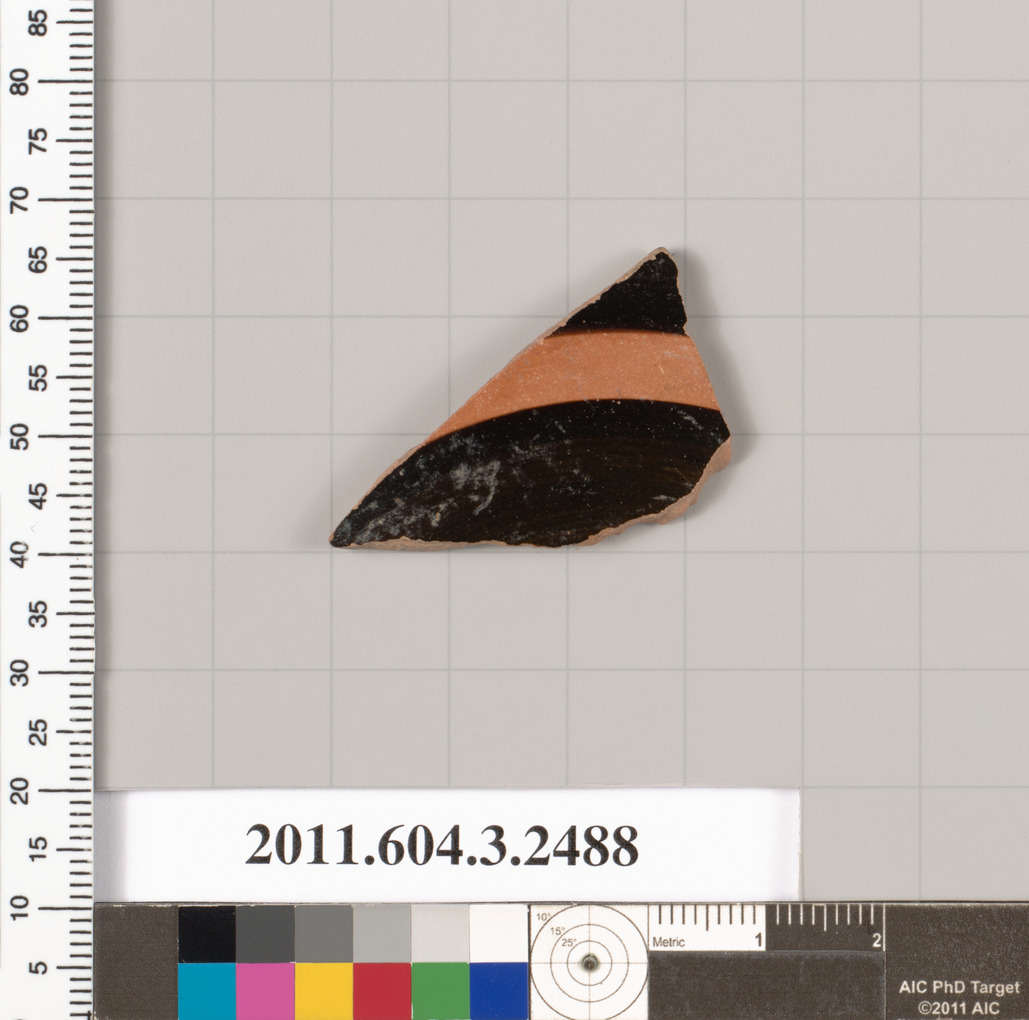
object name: kylix fragment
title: Terracotta fragment of a kylix (drinking cup)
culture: greek, attic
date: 600-401 BCE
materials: terracotta